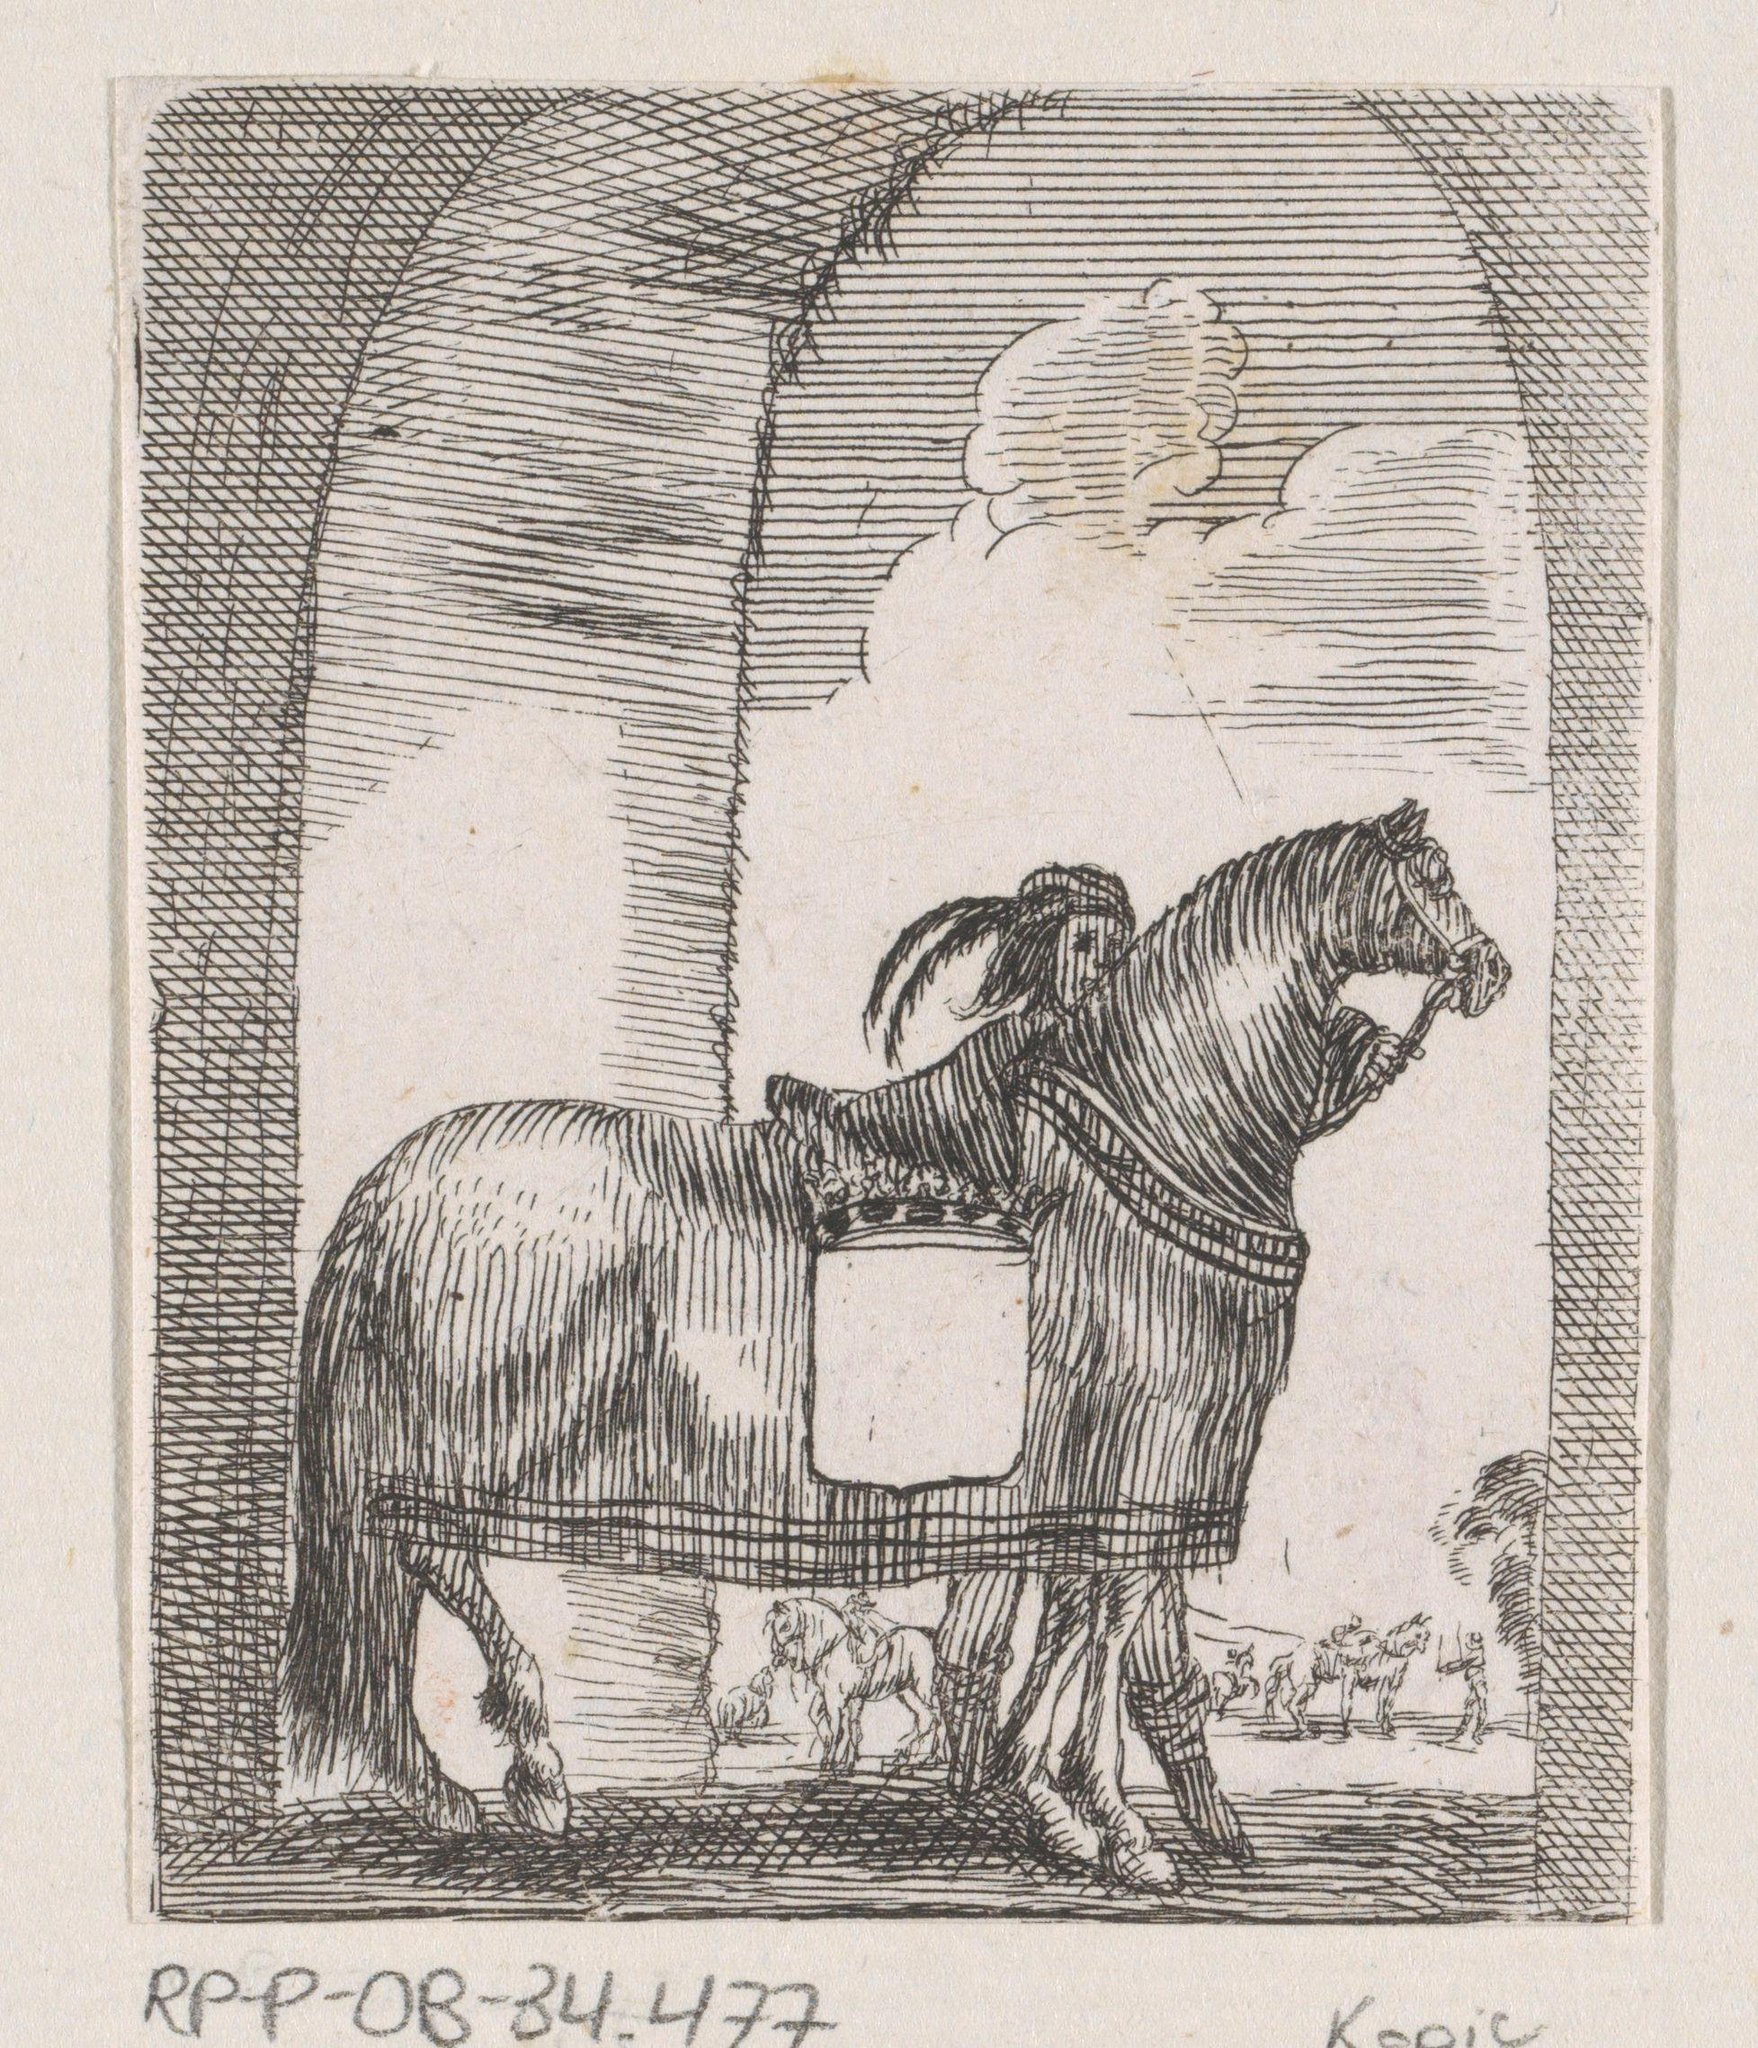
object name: print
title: Diverse oefeningen van de cavalerie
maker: Anonymous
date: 1620-1664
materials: paper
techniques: etching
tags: horse, groom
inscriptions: collector's mark: Lugt 240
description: Een stalknecht en paard in een doorgang.